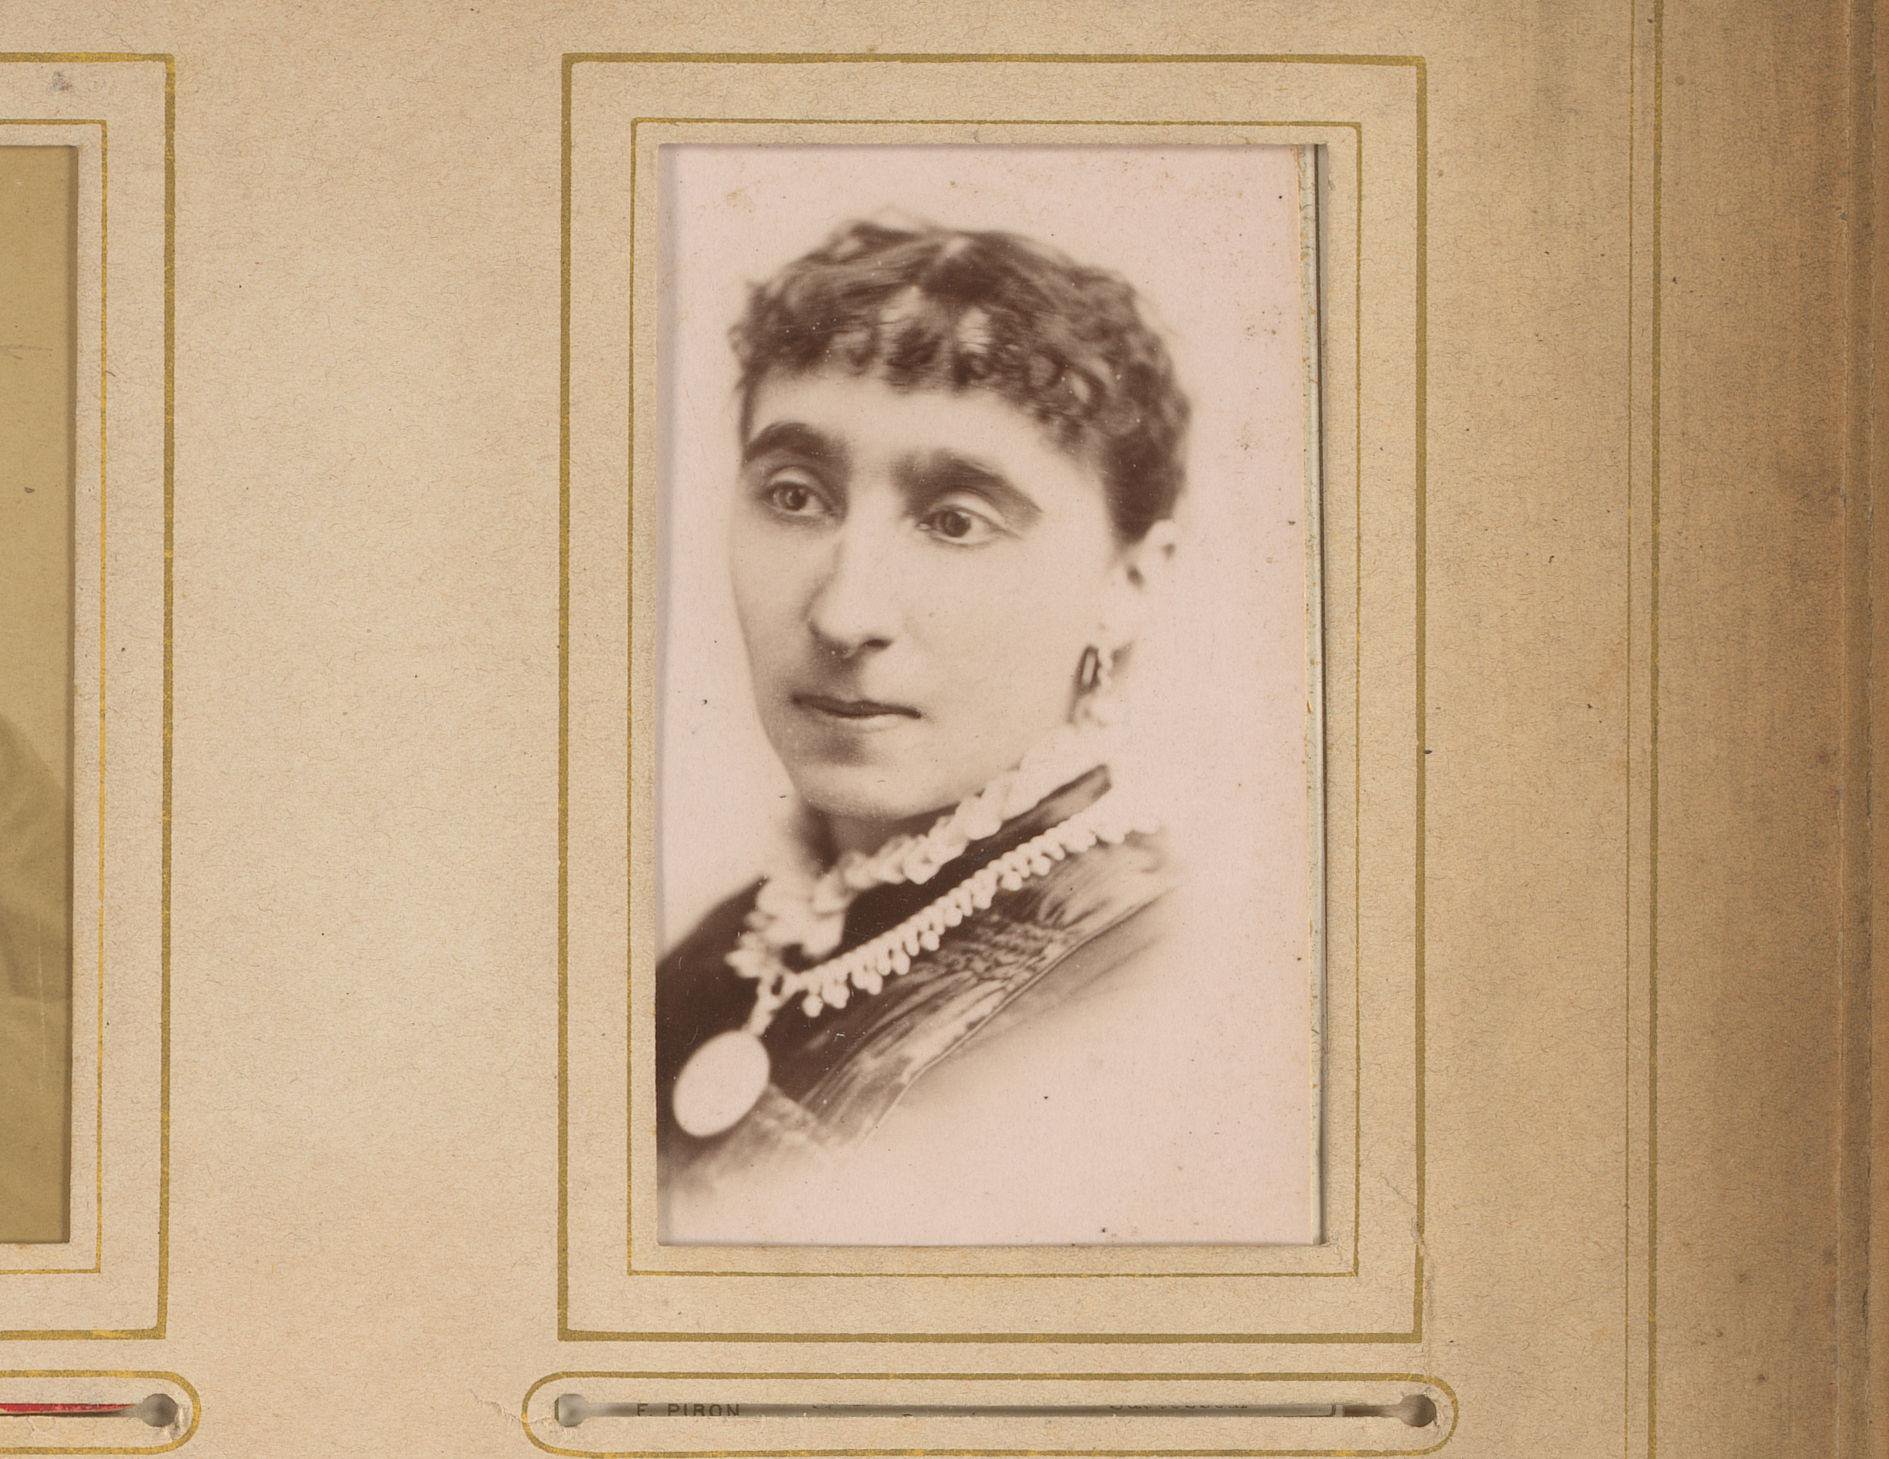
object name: photograph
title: Portret van een vrouw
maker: françois piron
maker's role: fotograaf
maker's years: 1835-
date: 1870-1900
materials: cardboard, photographic support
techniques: albumen print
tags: adult woman, historical persons